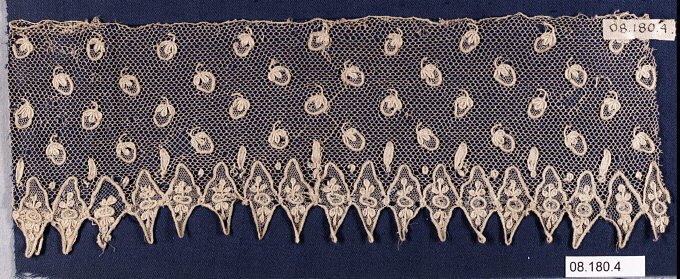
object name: fragment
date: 1801-1900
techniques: lace